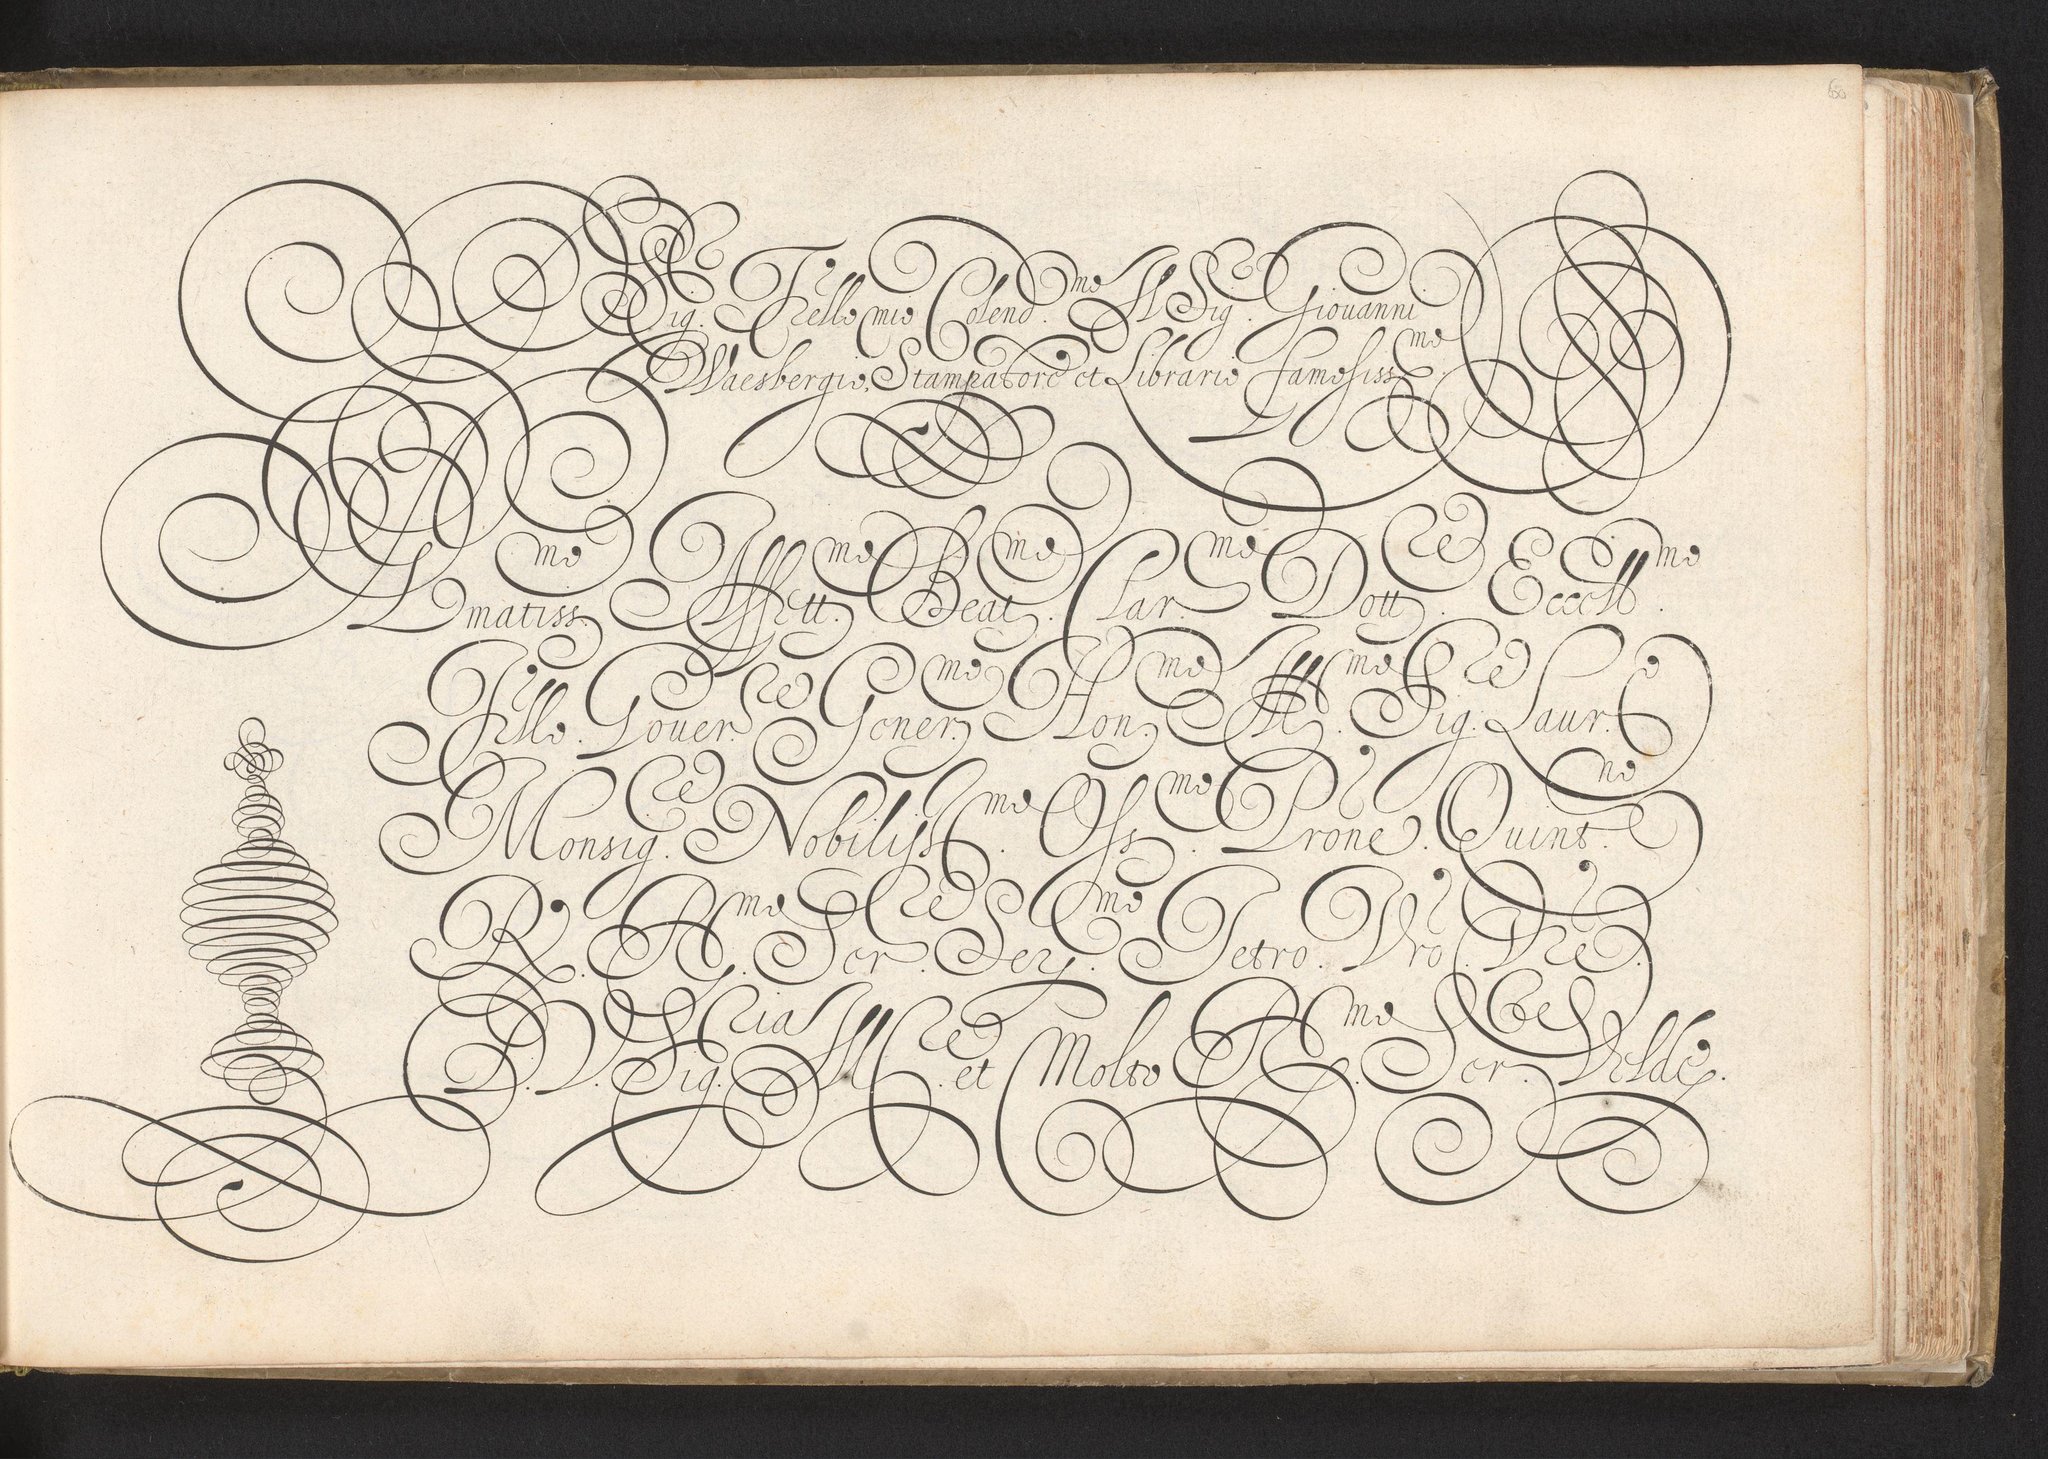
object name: print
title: Spieghel der schrijfkonste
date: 1605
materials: paper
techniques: engraving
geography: haarlem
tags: calligraphy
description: Schrijfvoorbeeld met de aanhef: Sig. fr[at]ello mio colend. il sig. Giovanni Waesbergio ... Daaronder zes regels tekst in het Latijn, voornamelijk bestaande uit afkortingen: Amo ... Links een vaas of ciborie in krulwerk. De prent maakt deel uit van een album.